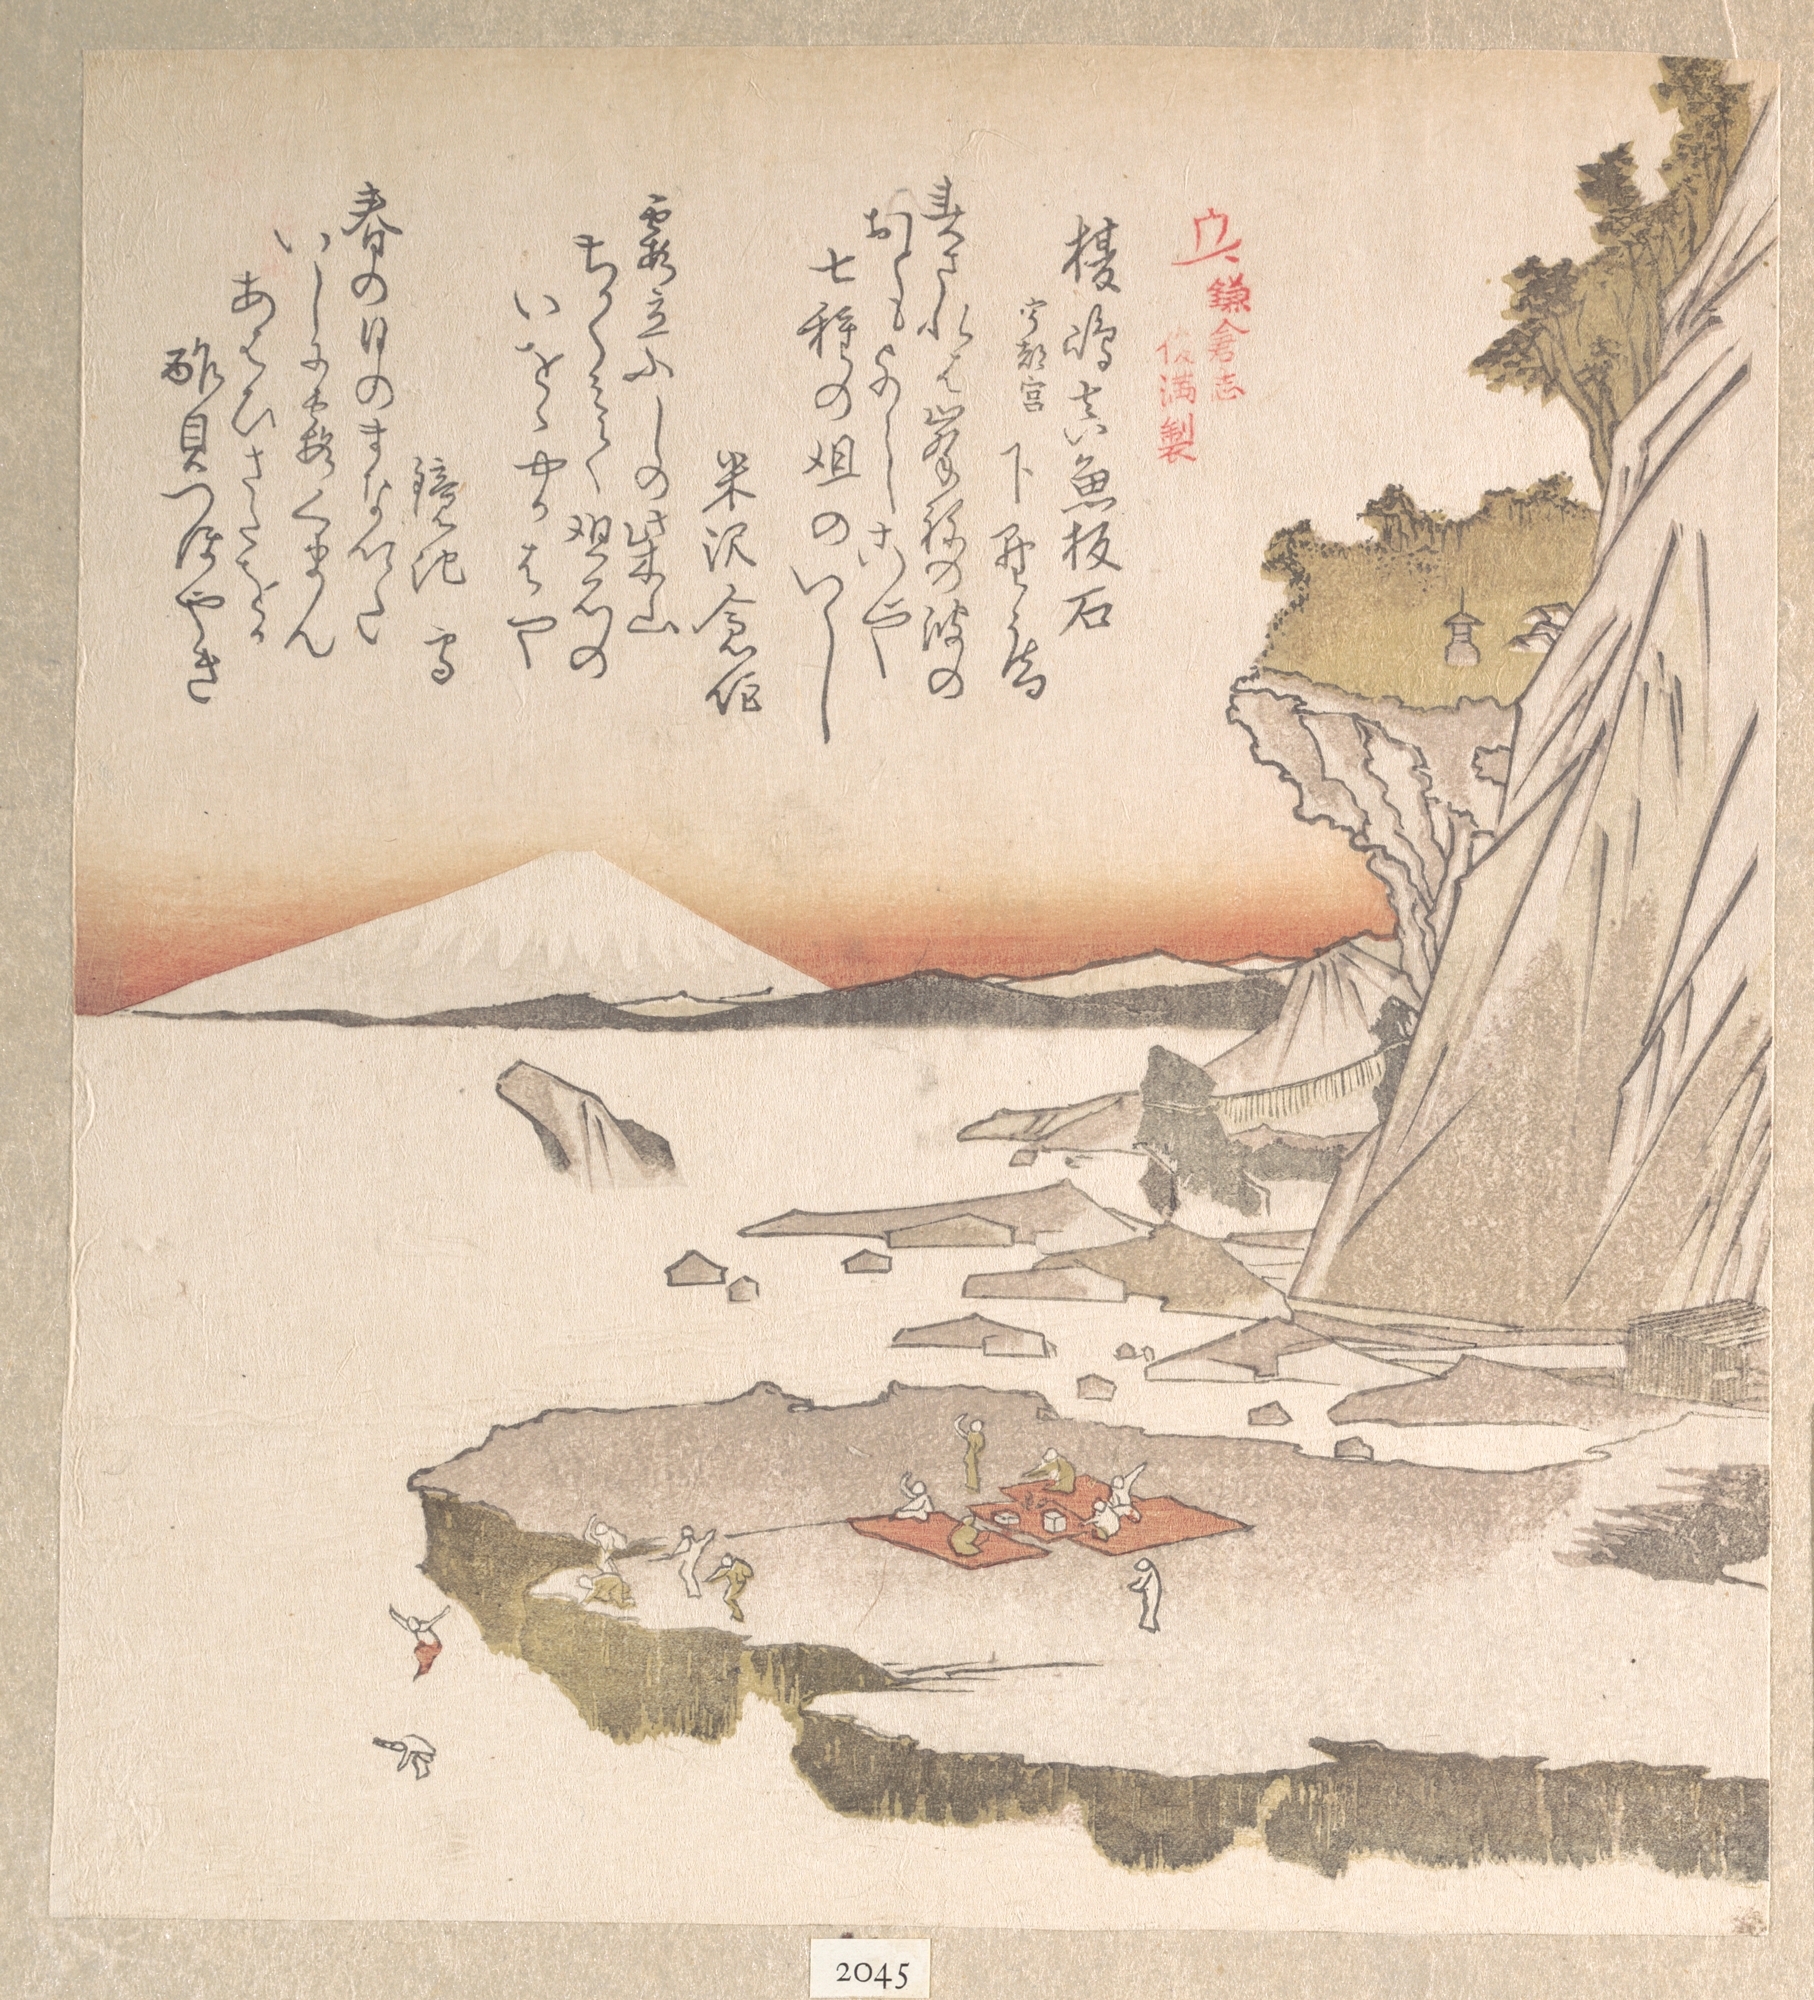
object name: print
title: History of Kamakura: Enoshima Island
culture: japanese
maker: totoya hokkei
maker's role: artist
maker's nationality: japanese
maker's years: 1780-1850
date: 1801-1900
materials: ink, paper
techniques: surimono, woodblock print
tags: human figures,mountains,trees